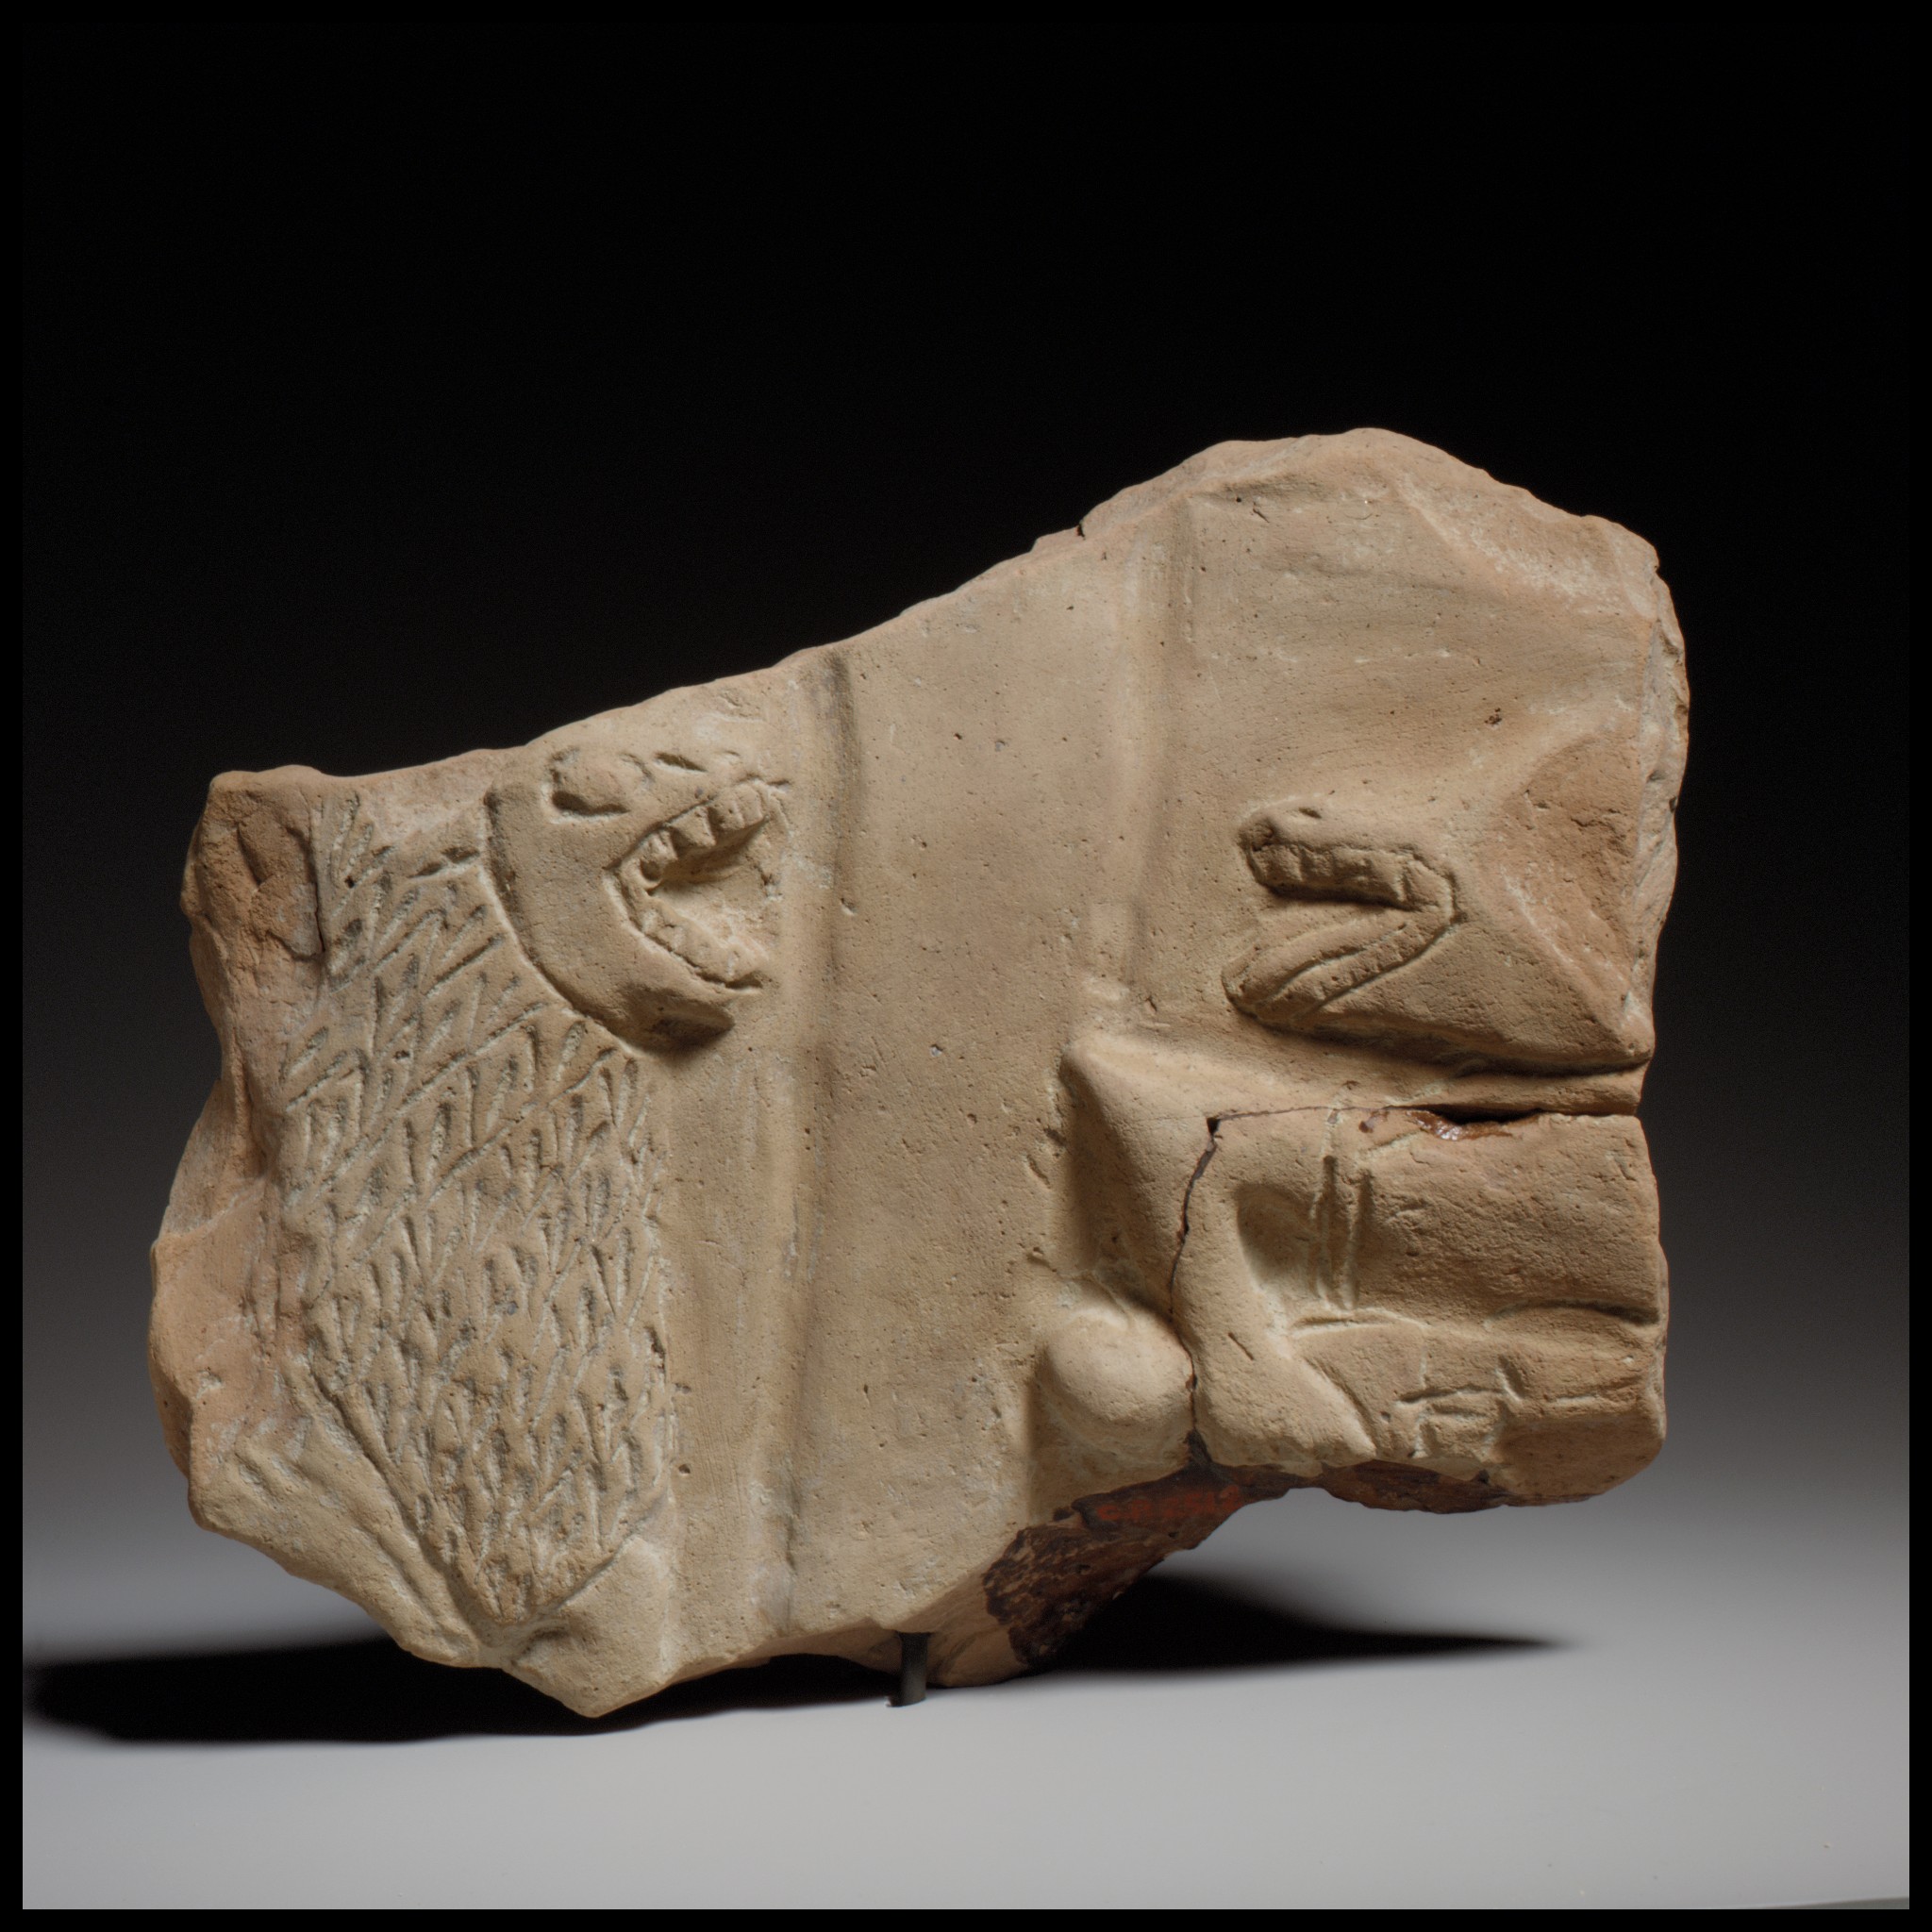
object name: cuirass with lion, fragment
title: Fragment of a large terracotta statue of a man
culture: cypriot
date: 600-501 BCE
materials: terracotta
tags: animals